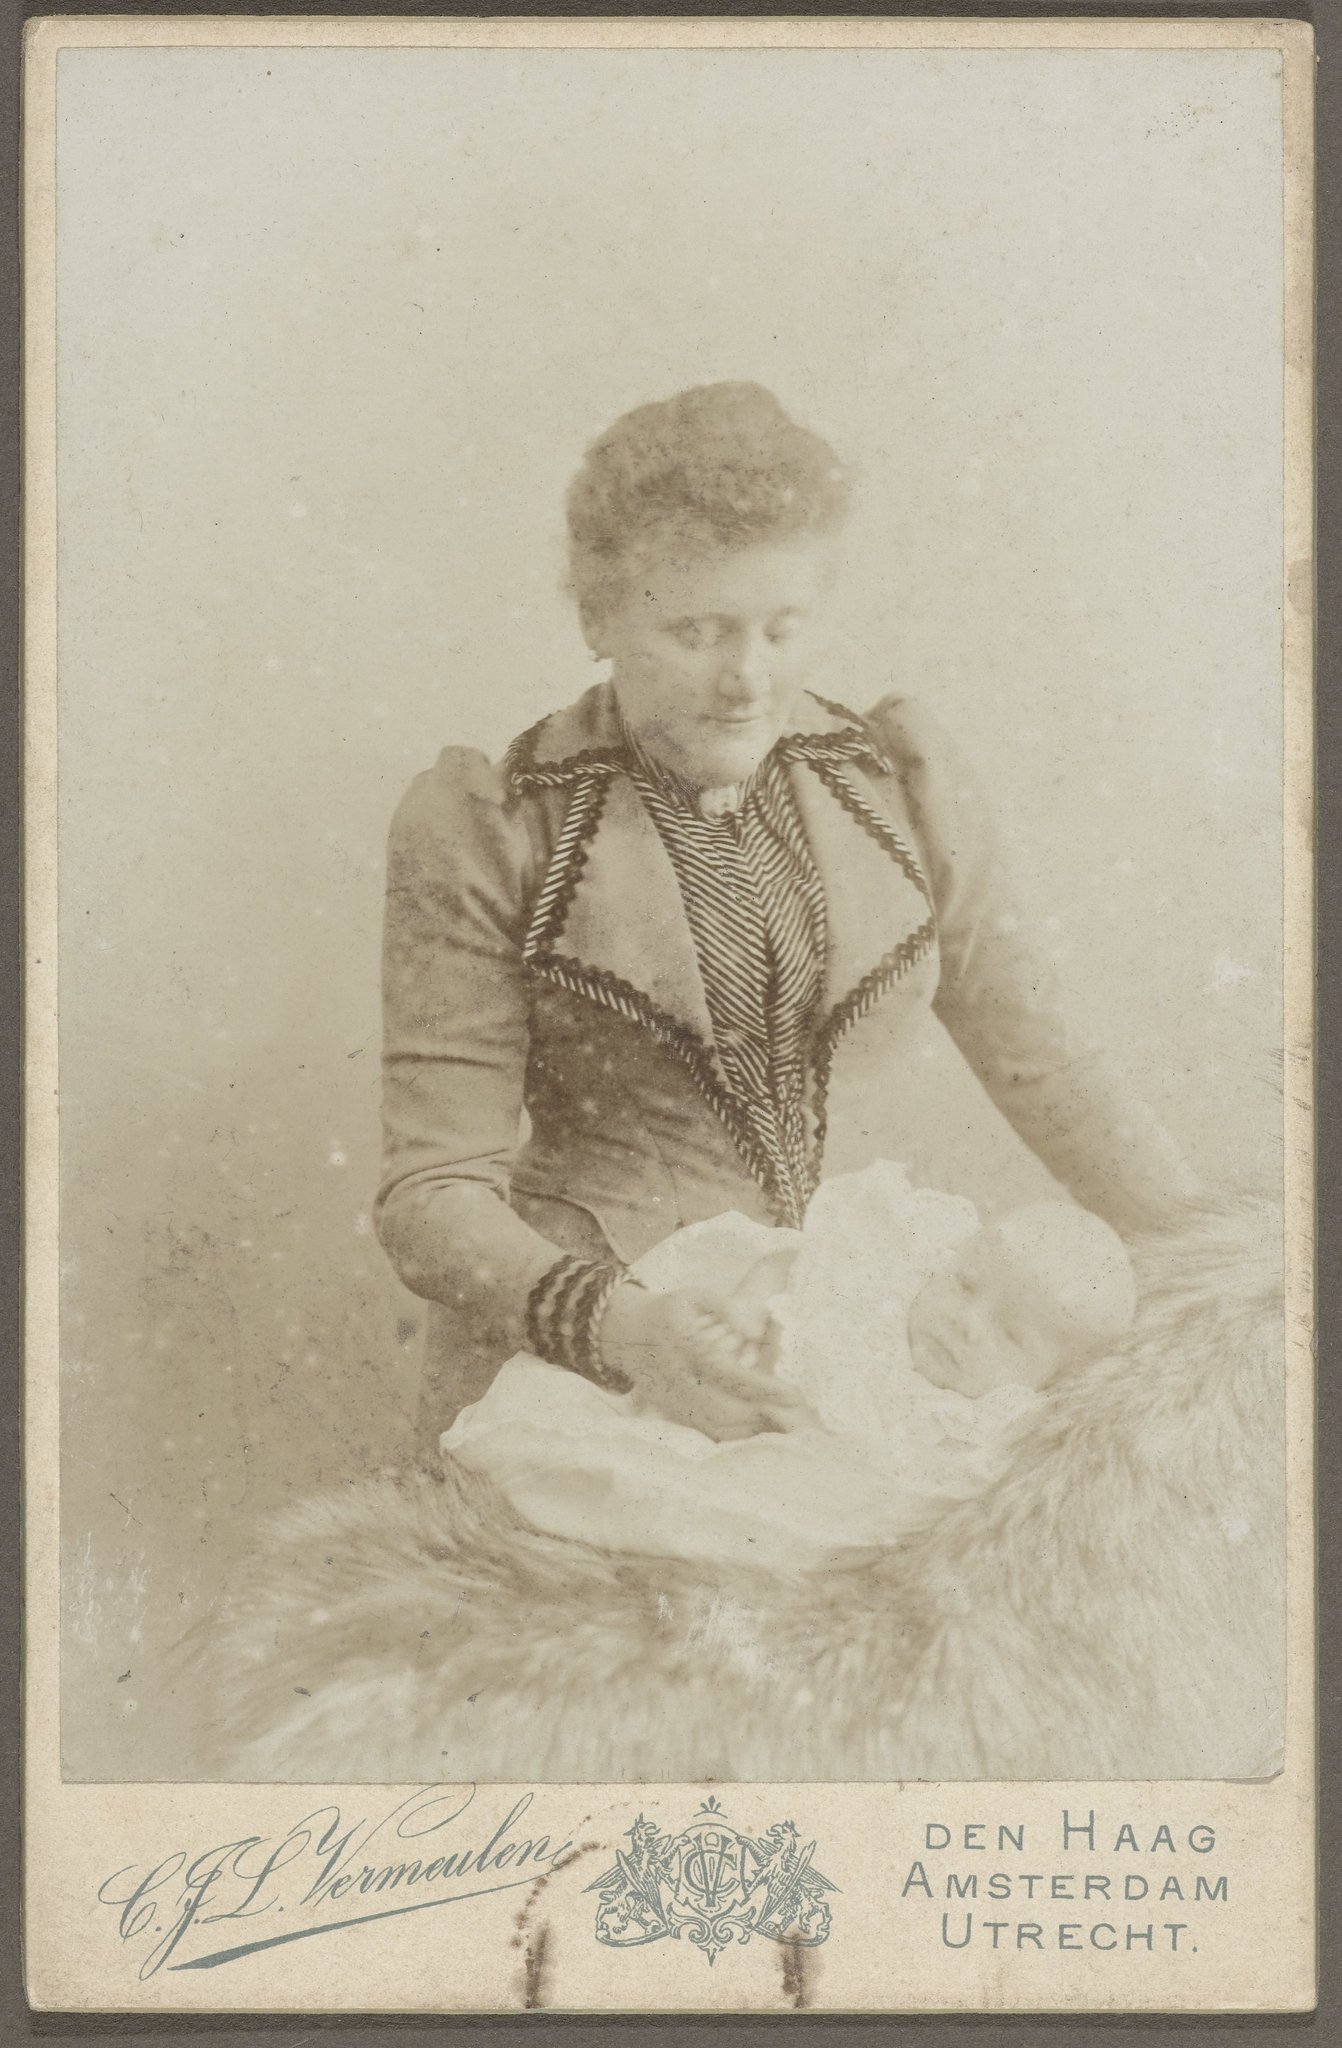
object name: photograph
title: Portret van Grietje Vermeulen-Luitjes met een baby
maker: cornelis johannes lodewicus vermeulen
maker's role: fotograaf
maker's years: 1861-1936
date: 1888-1900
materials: paper, cardboard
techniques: collodion silver print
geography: amsterdam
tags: historical persons - bb - woman, mother and baby or young child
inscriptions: inscription: ‘Oma met?’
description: Grietje Vermeulen-Luitjes staat in een jurk met pofmouwen bij de baby die in een witte jurk op een kleed ligt.